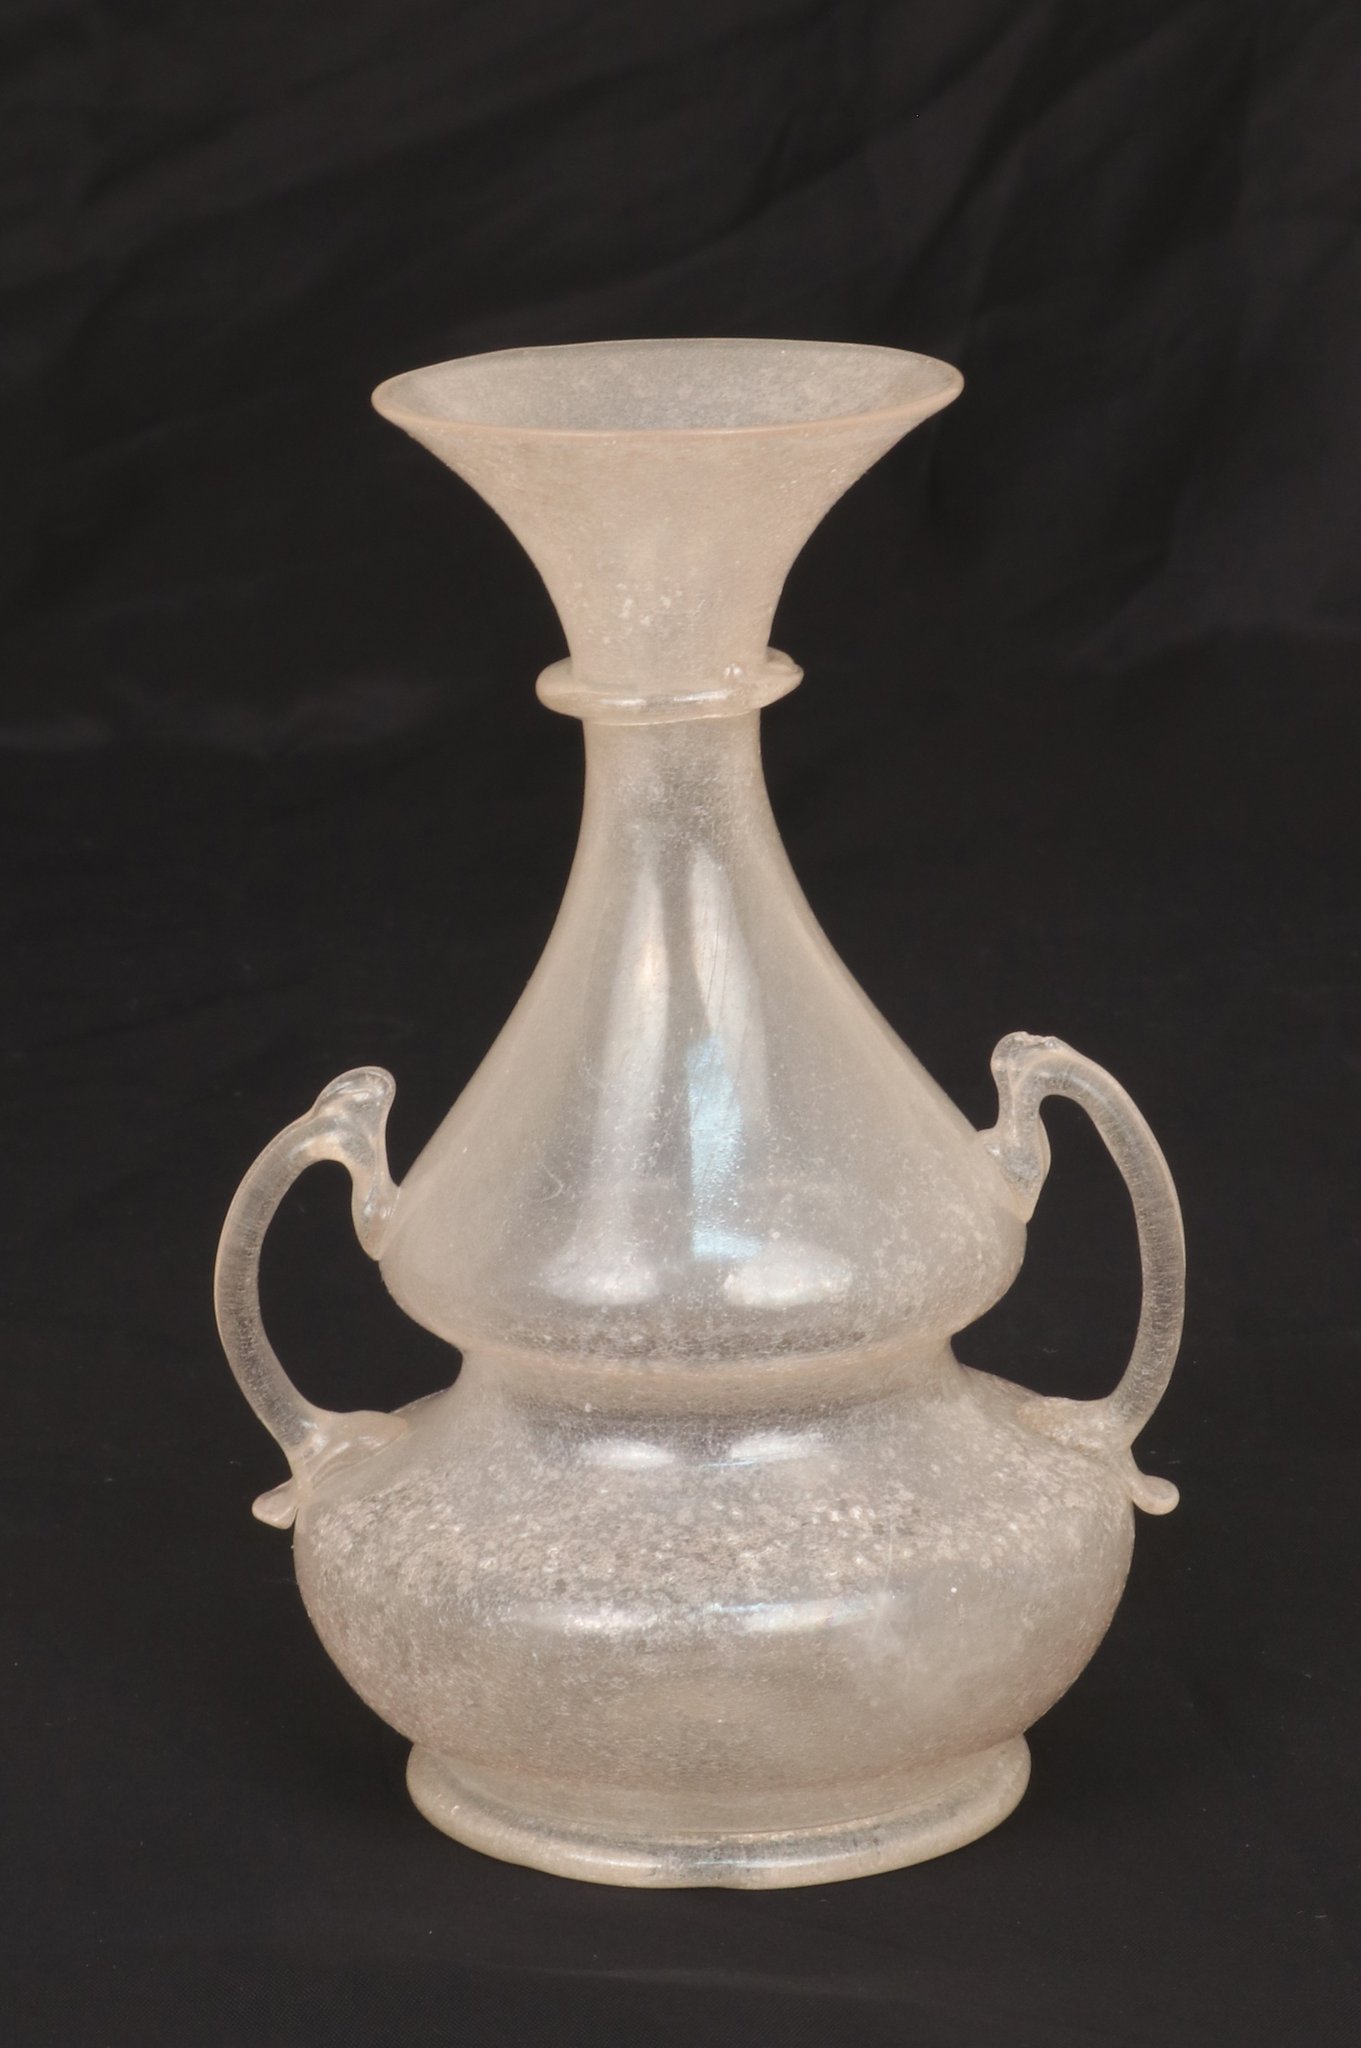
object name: vase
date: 1601-1700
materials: glass